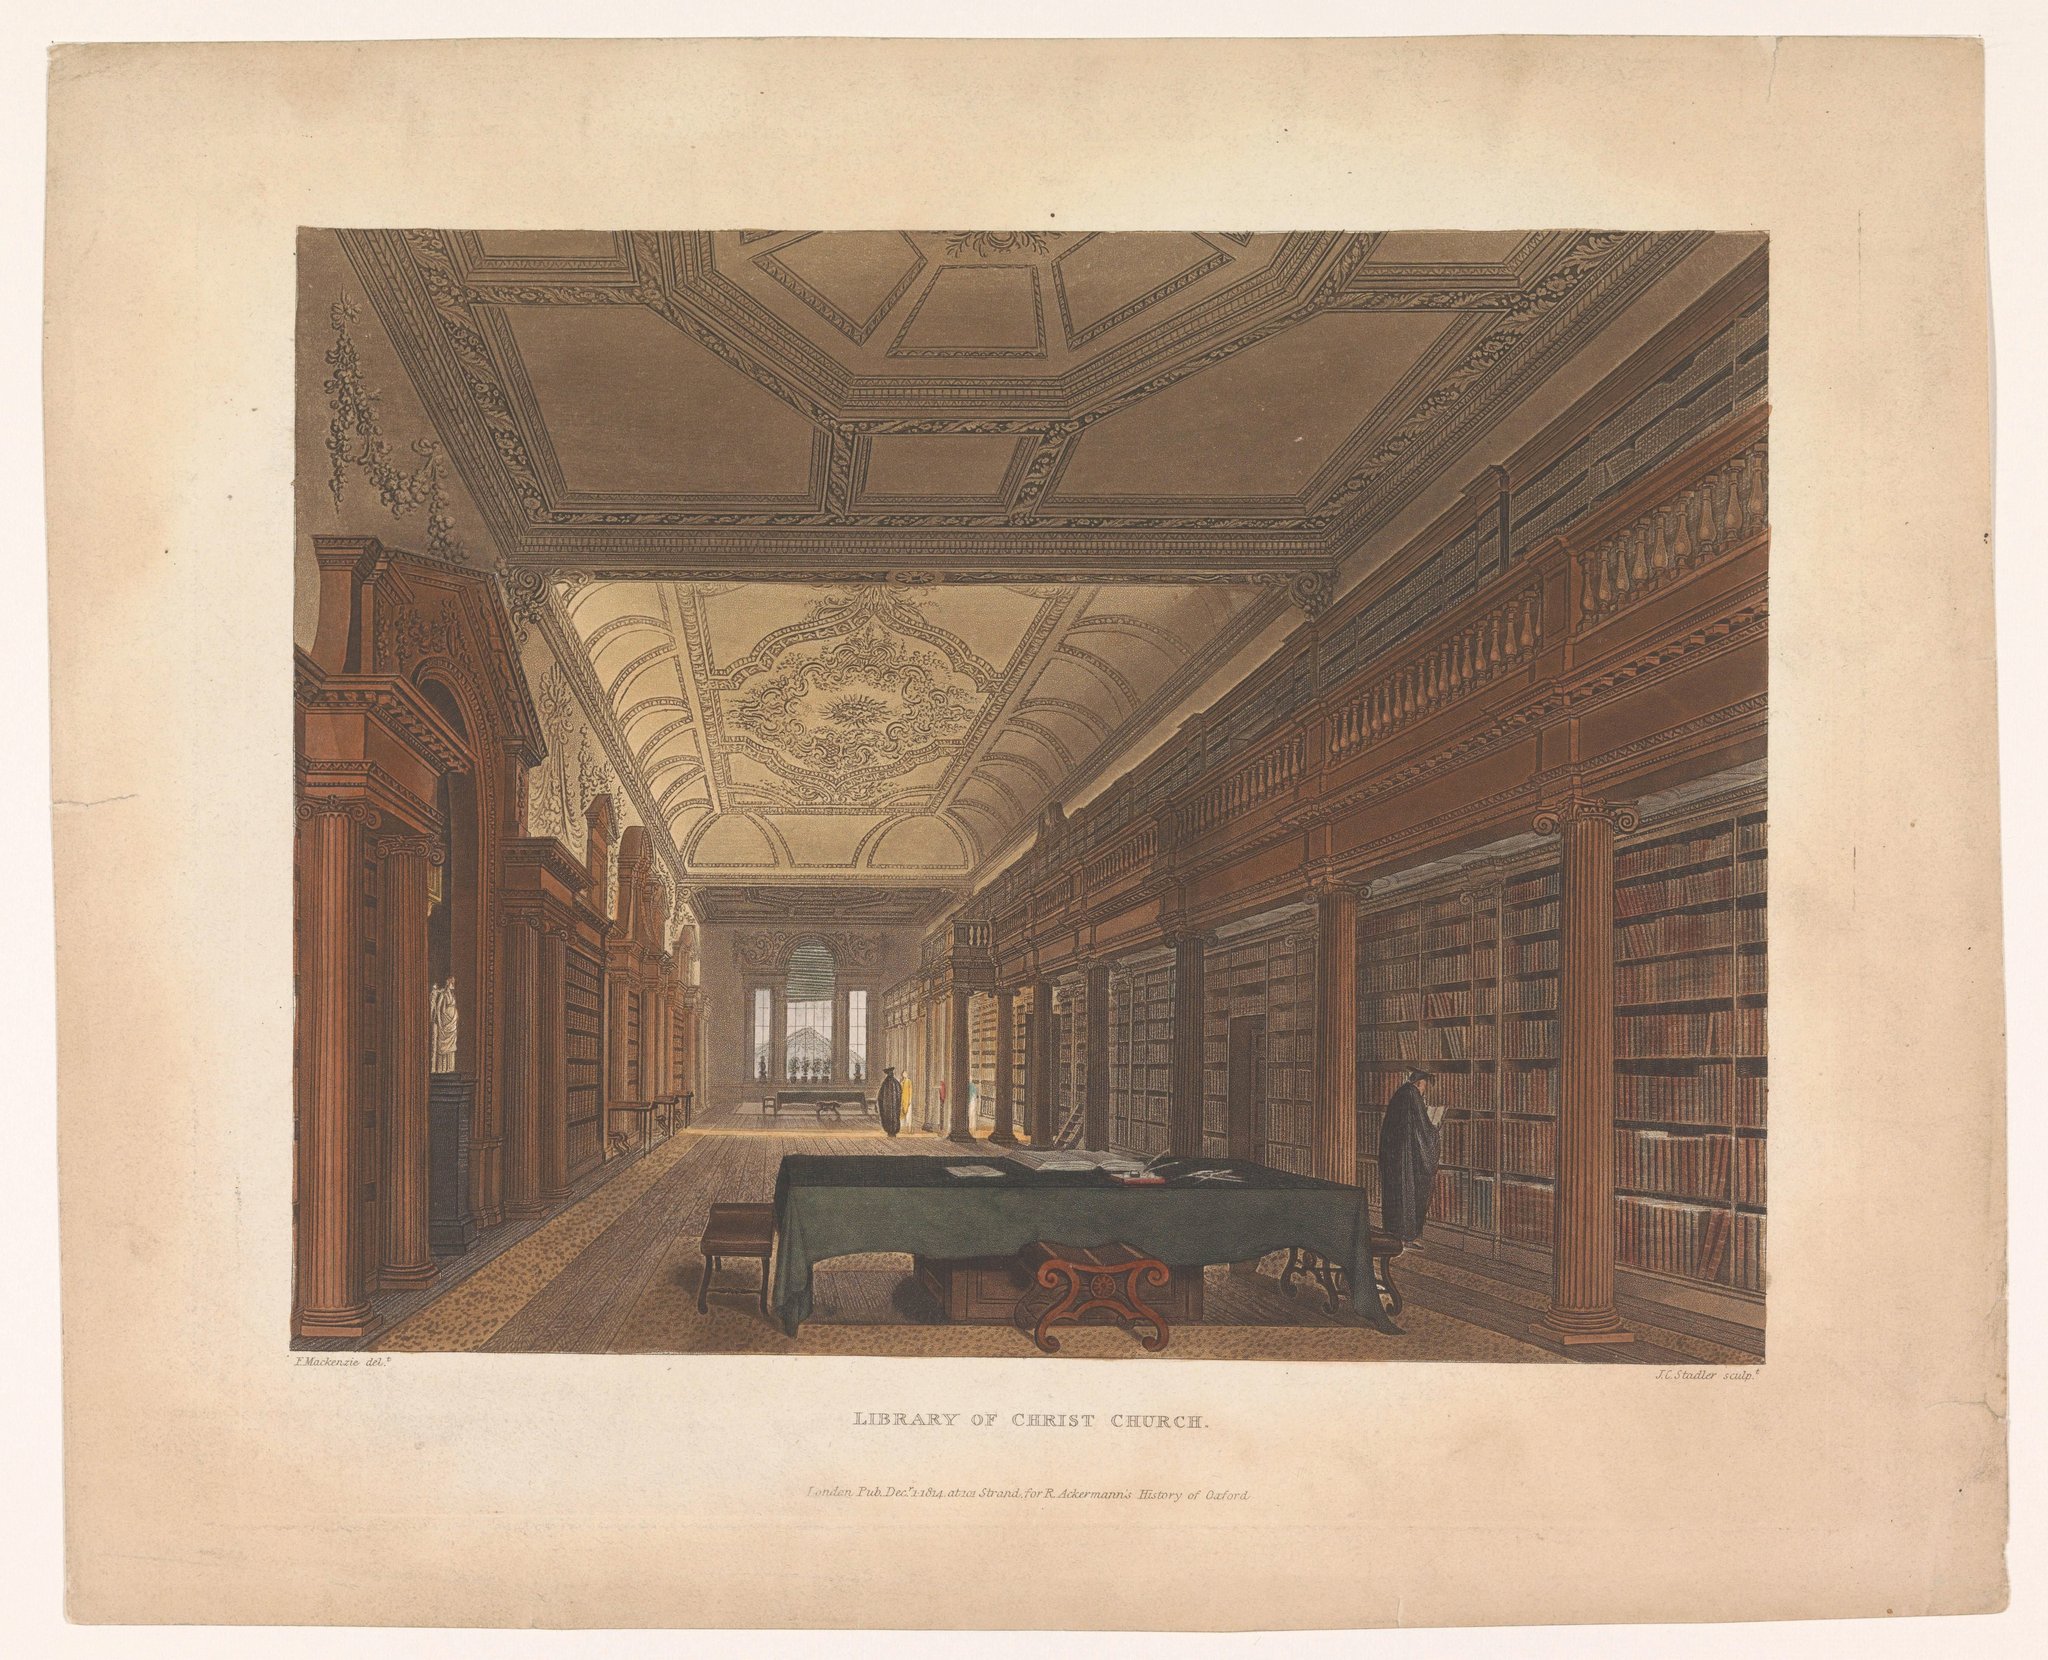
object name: illustration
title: Library of Christ Church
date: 1814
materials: paper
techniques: aquatint, etching, hand coloring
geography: london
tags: writing-table, writing-desk, university, public library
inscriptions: collector's mark: Lugt 4779, collector's mark: Lugt 2228, collector's mark: Lugt 4780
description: Interieur van de bibliotheek van Christ Church met op de voorgrond een schrijftafel. Rechts een man gekleed in een toga en een baret voor een boekenkast.